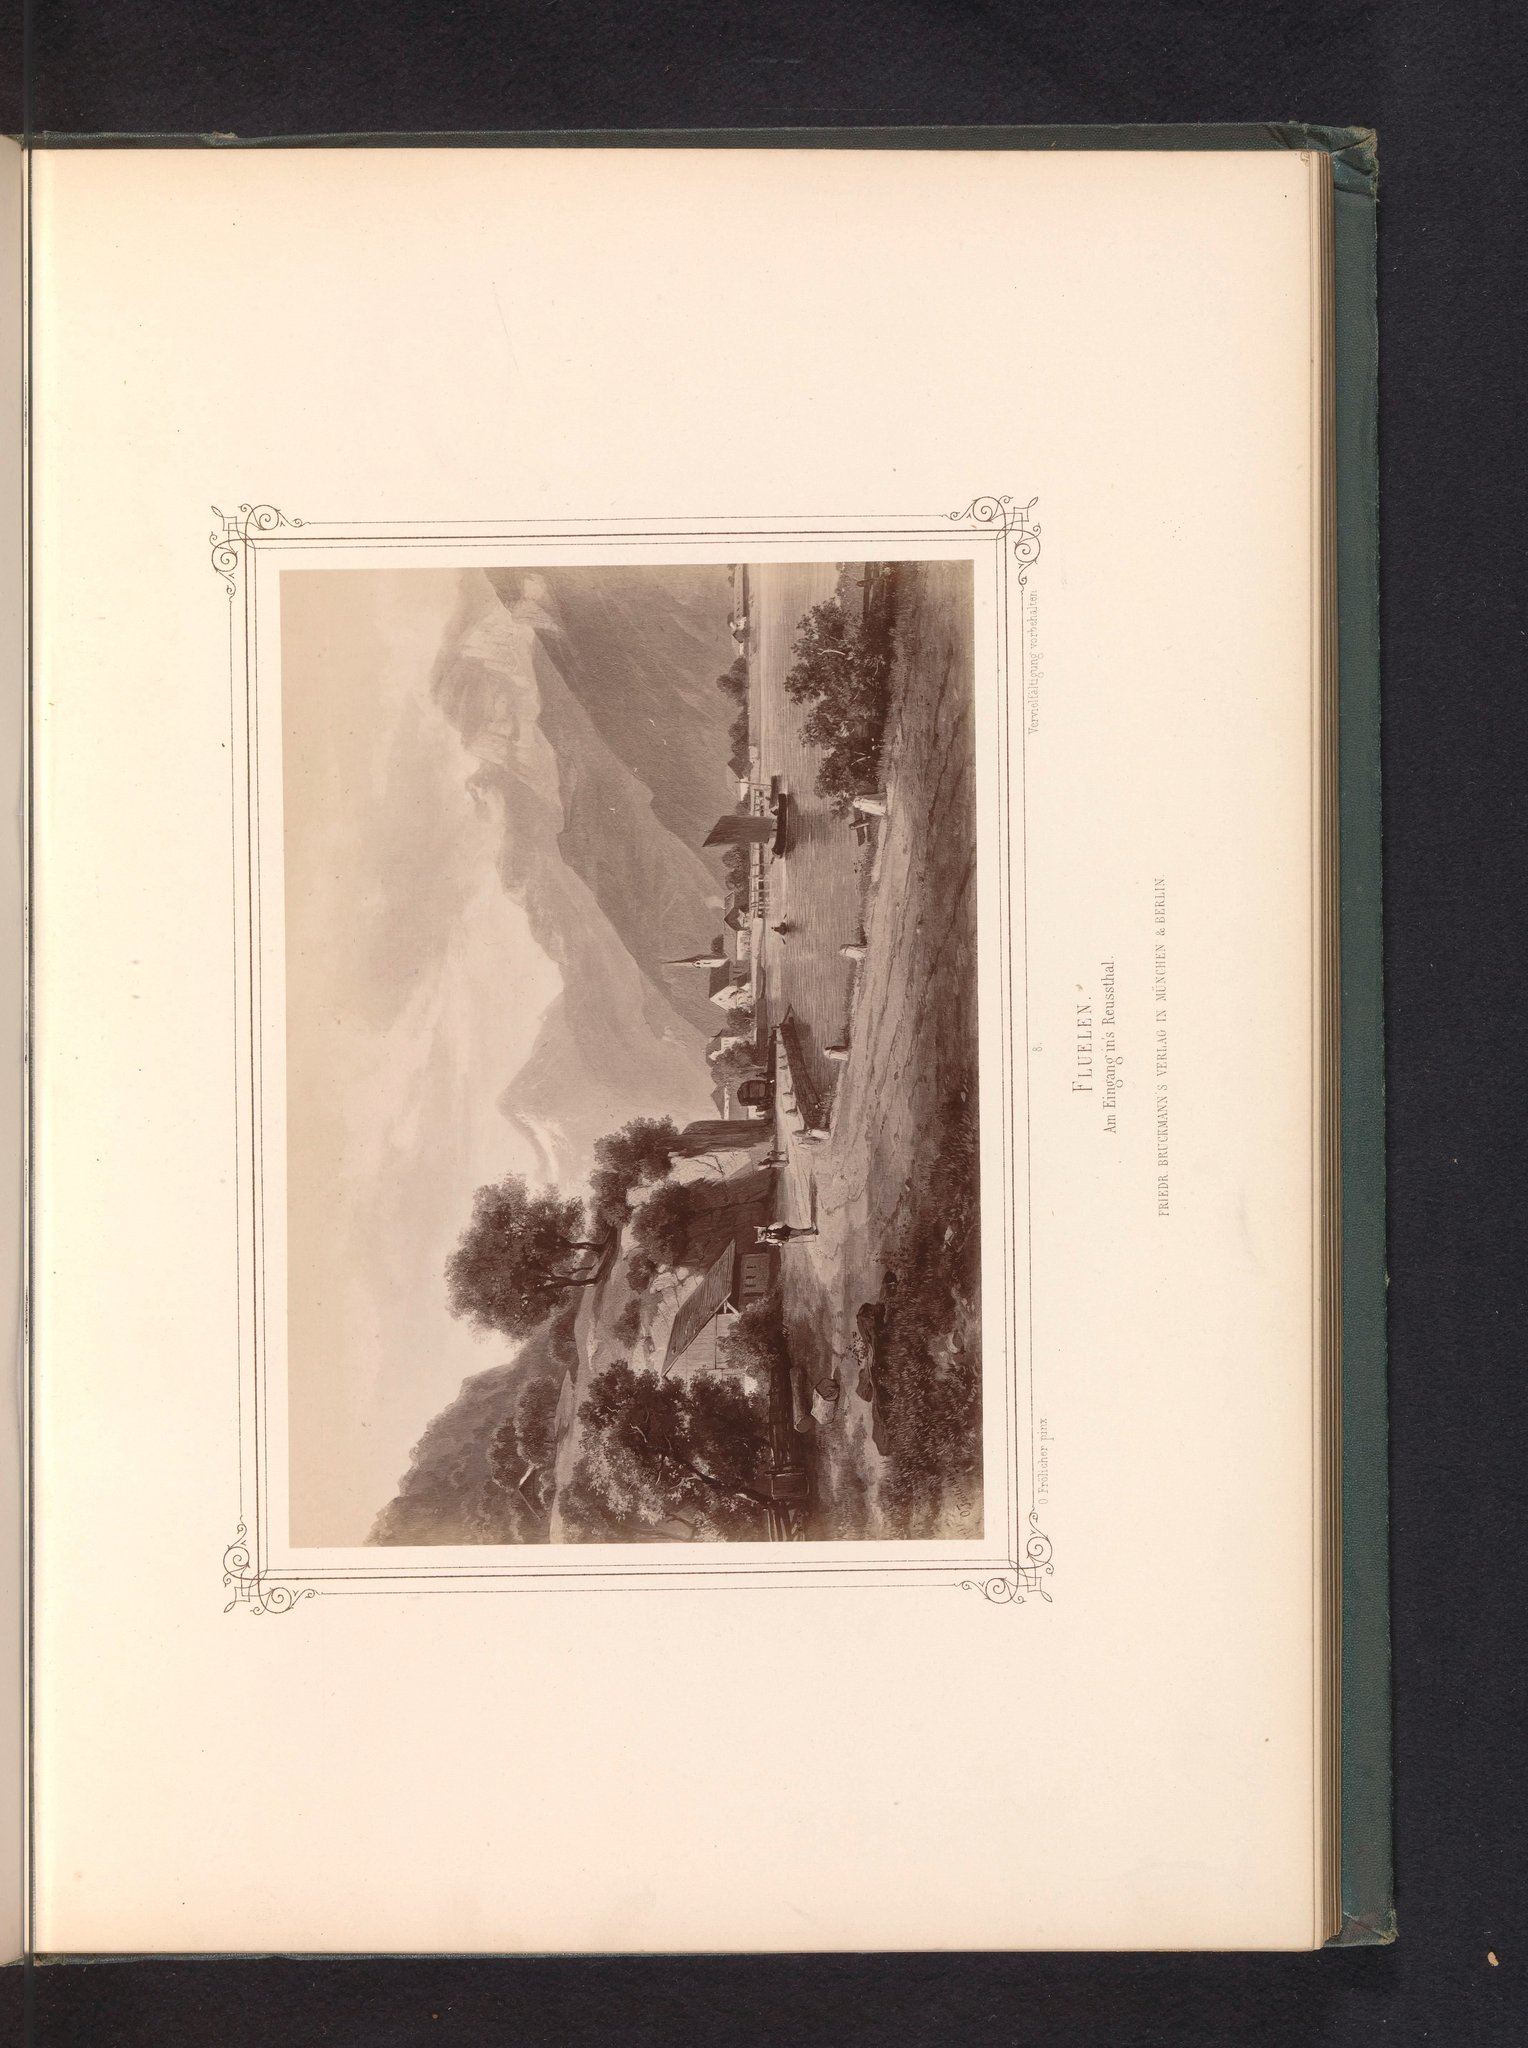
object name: page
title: Fotoreproductie van een schilderij van Flüelen aan het Vierwoudstrekenmeer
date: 1863-1873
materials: photographic support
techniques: albumen print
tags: city-view, and landscape with man-made constructions, lake, mountains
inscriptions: number: ‘8.’